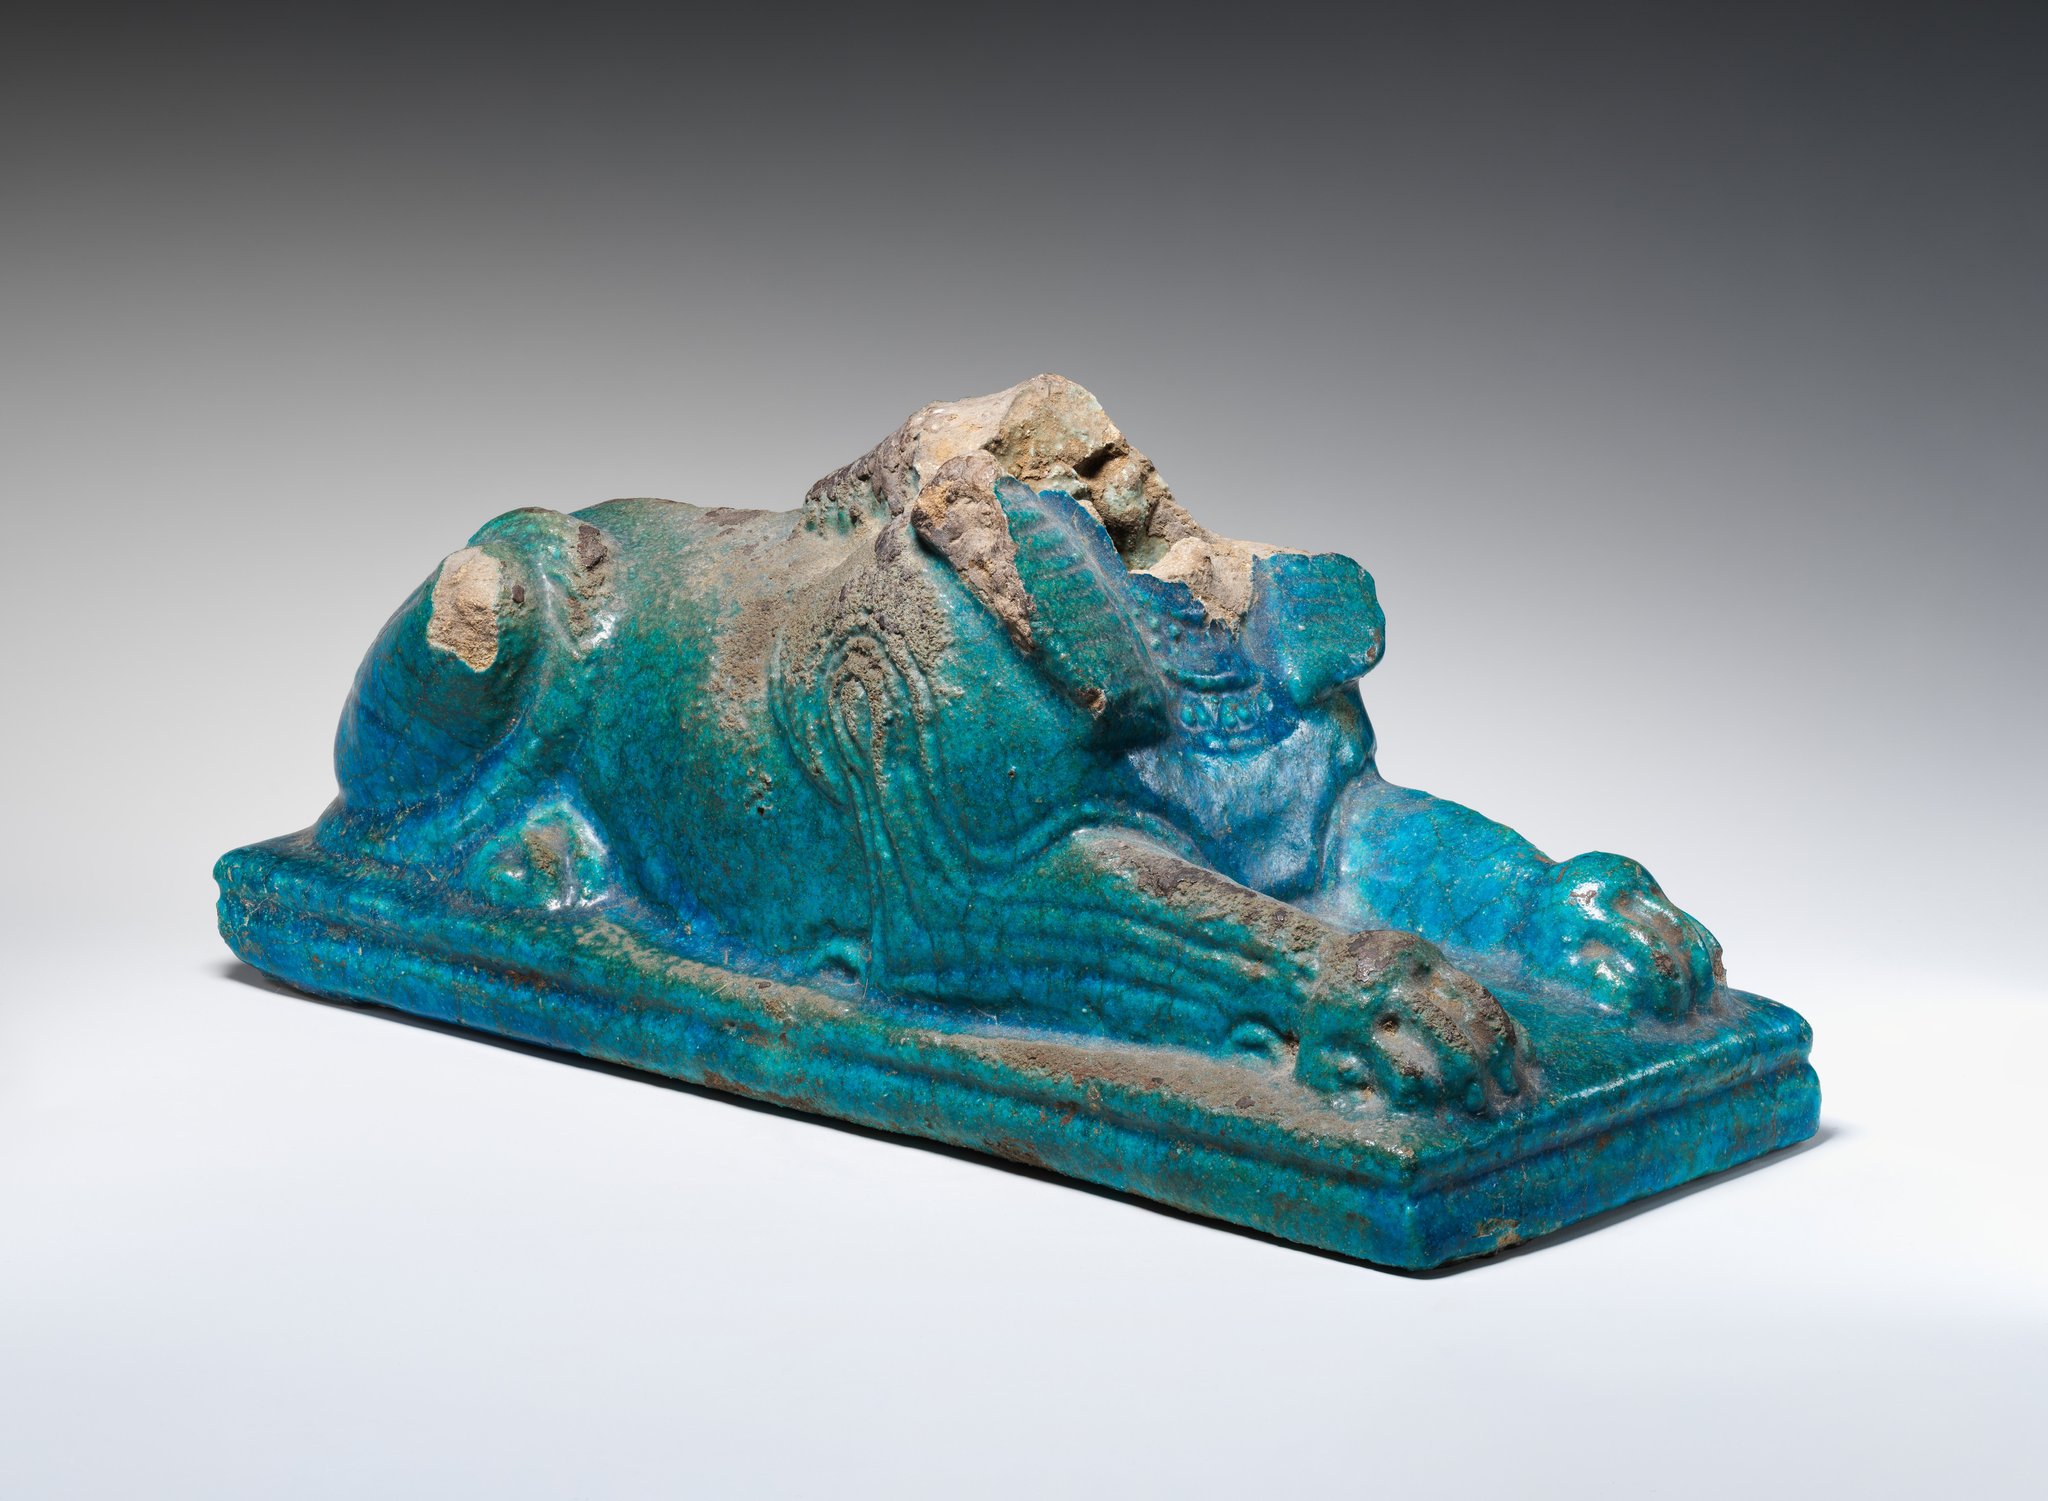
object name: sphinx, headless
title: Sphinx with head broken away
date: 1-200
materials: faience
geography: egypt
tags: sphinx